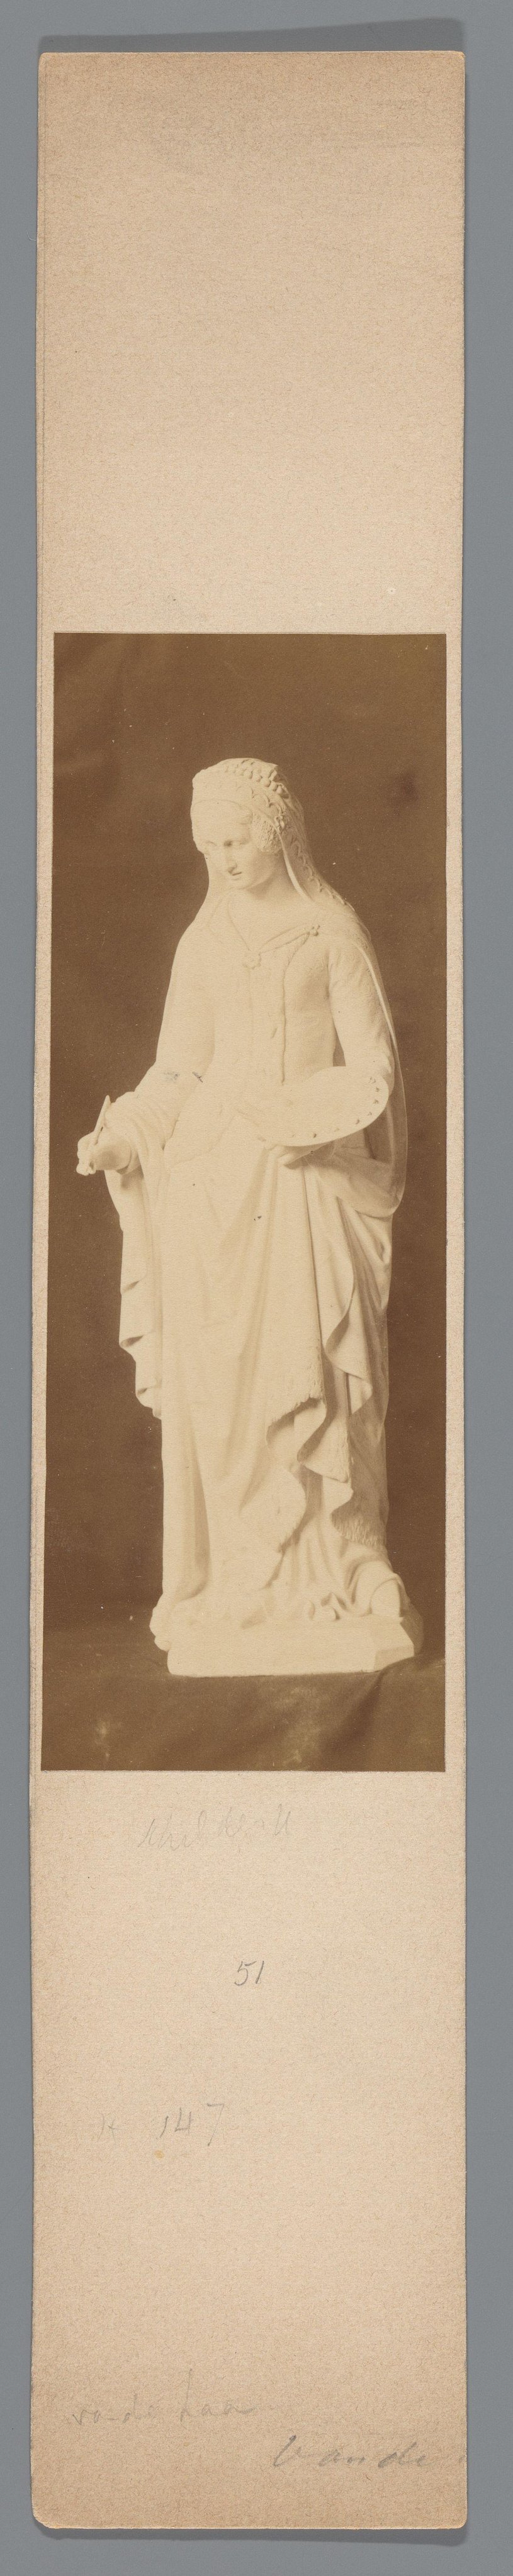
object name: photograph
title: Fotoreproductie van het beeldhouwwerk De Schilderkunst door Frans Karel van de Laar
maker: Anonymous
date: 1880-1887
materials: cardboard, paper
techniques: albumen print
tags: 'pictura', symbolic representations, allegories and emblems ~ painting; 'pittura' (ripa), piece of sculpture, reproduction of a piece of sculpture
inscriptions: inscription: ‘van de Laar / van de’, inscription: ‘schilderk/ 51/ 147’, collector's mark: Lugt 2228